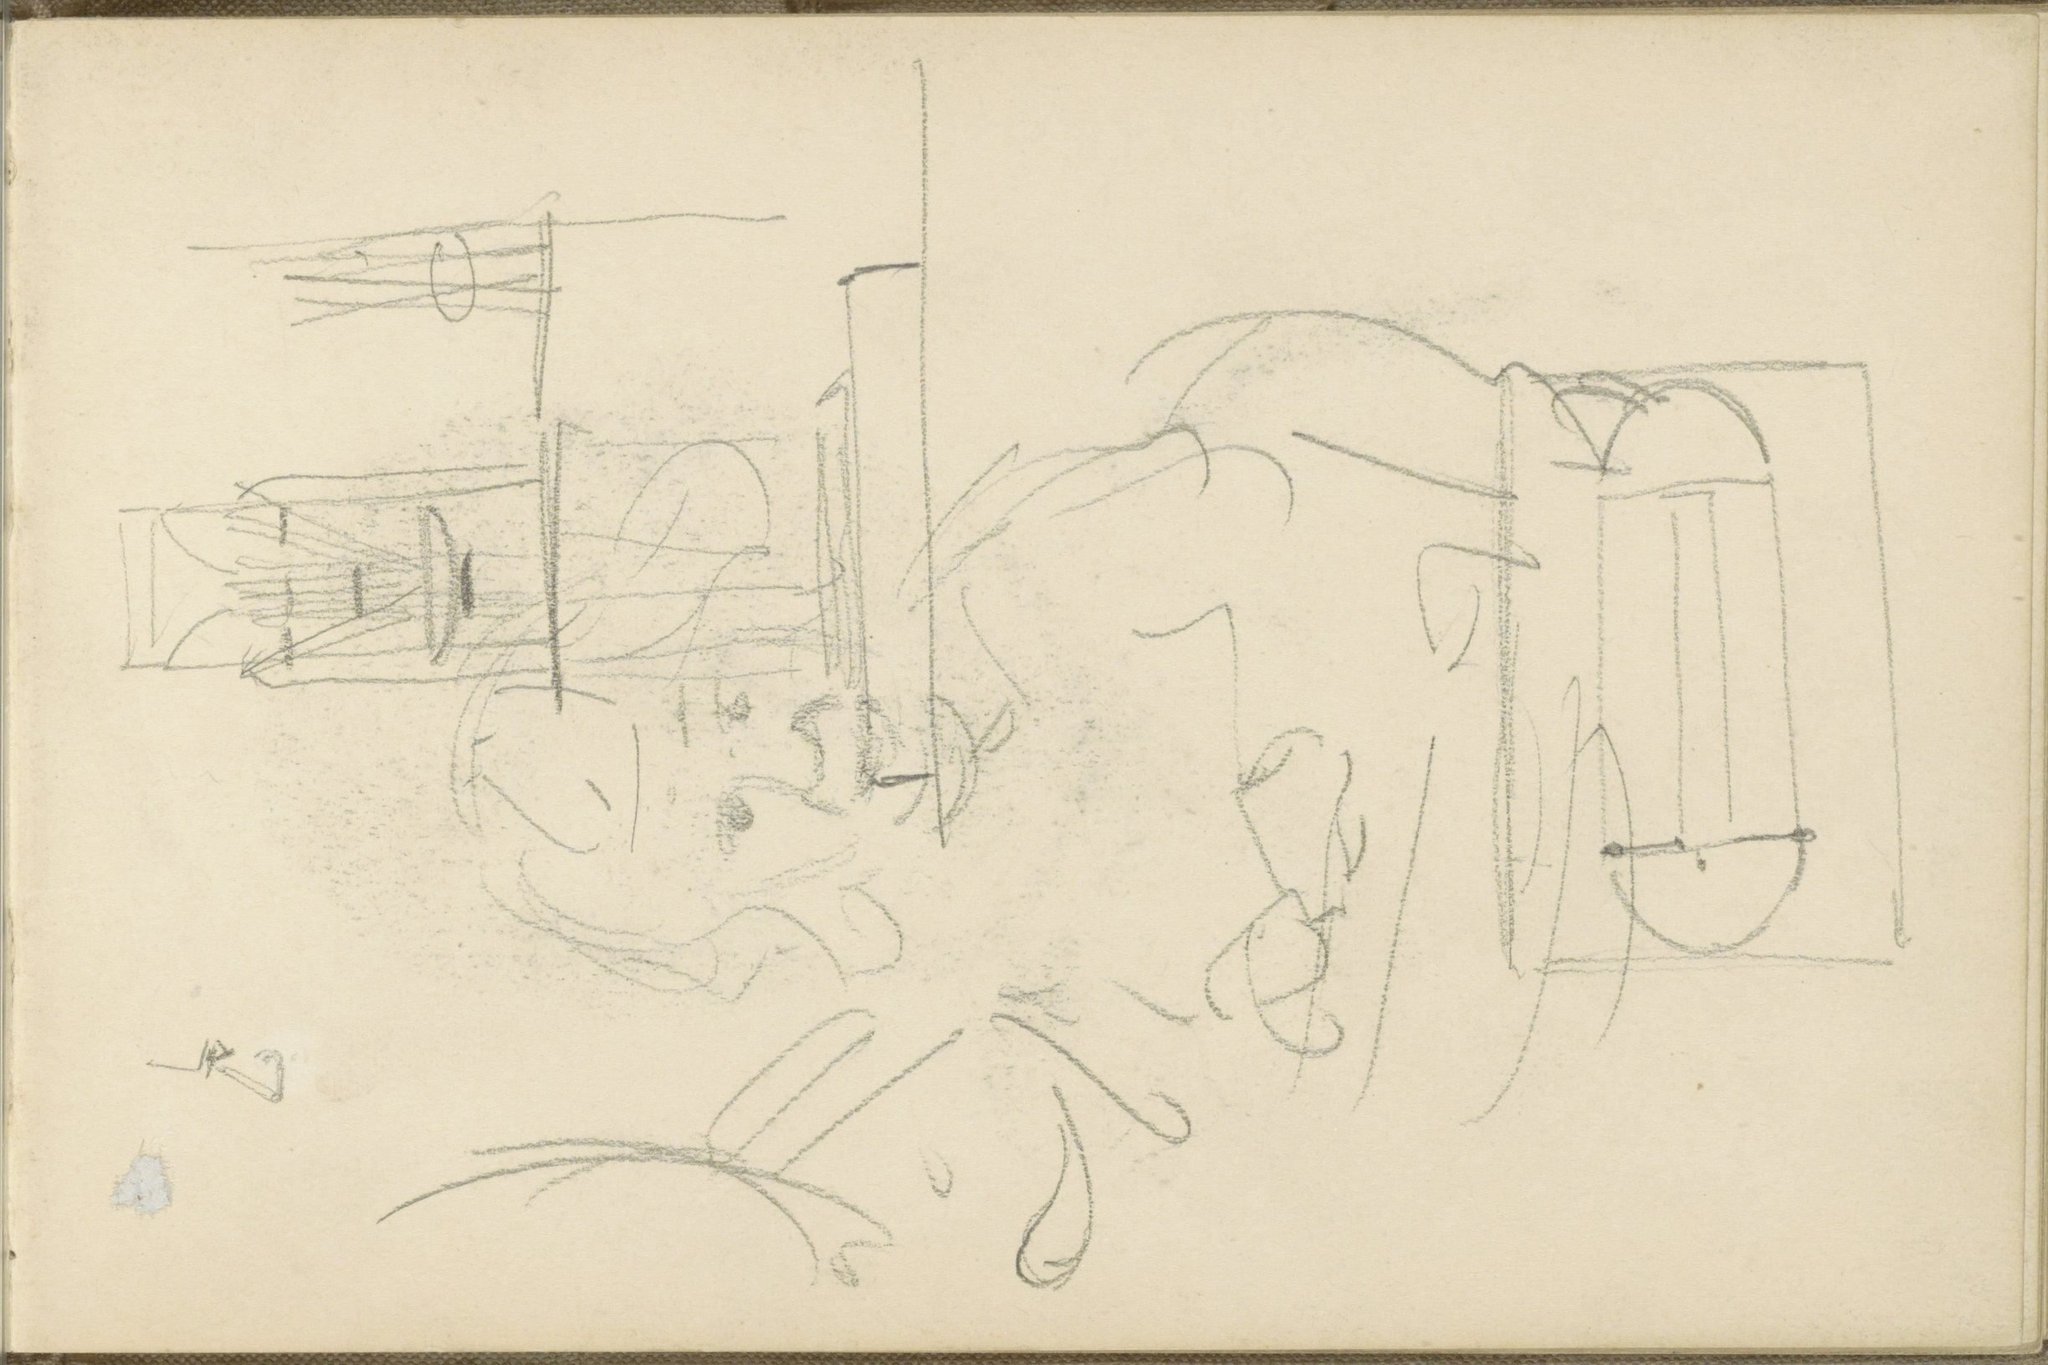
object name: sketchbook leaf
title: Studieblad, onder andere met een figuur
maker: carel adolph lion cachet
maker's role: draughtsman, print maker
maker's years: 1864-1945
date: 1905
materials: paper, pencil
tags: anatomy (non-medical)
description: Blad 7 recto uit een schetsboek met 27 bladen.